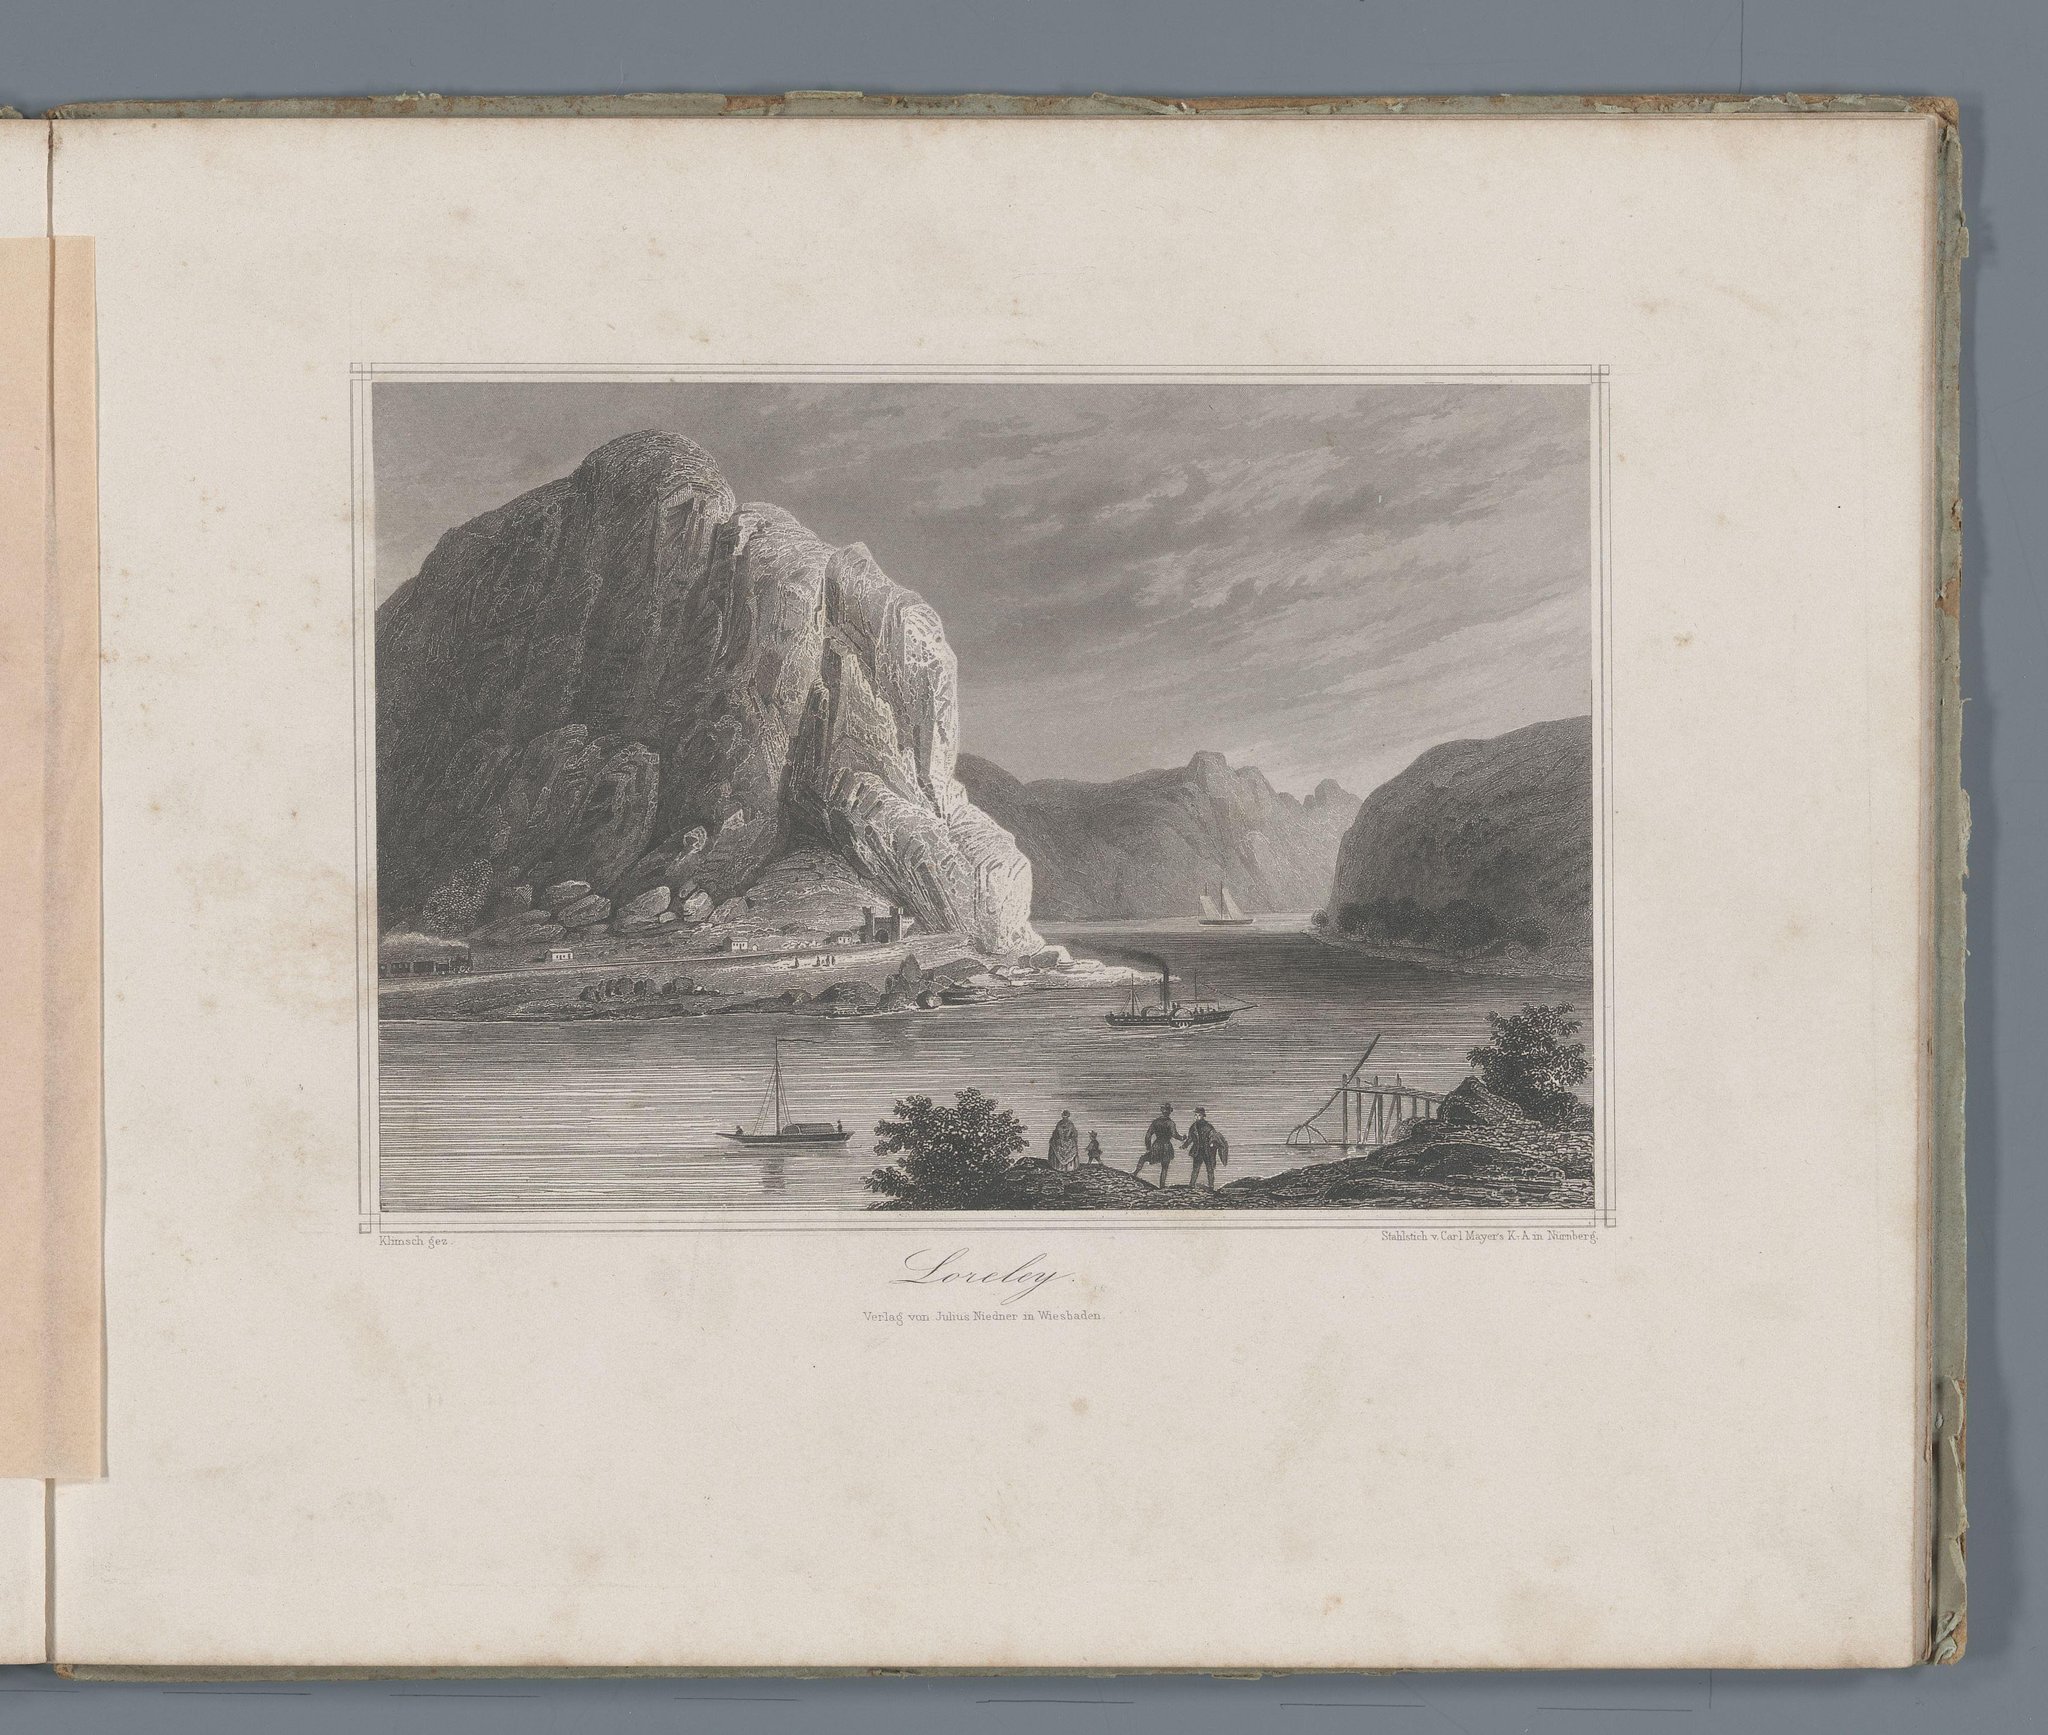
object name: print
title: Gezicht op de Loreley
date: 1822-1868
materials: paper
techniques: engraving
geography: wiesbaden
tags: river, inland cliff face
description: Deze prent maakt deel uit van een album met twaalf prenten.